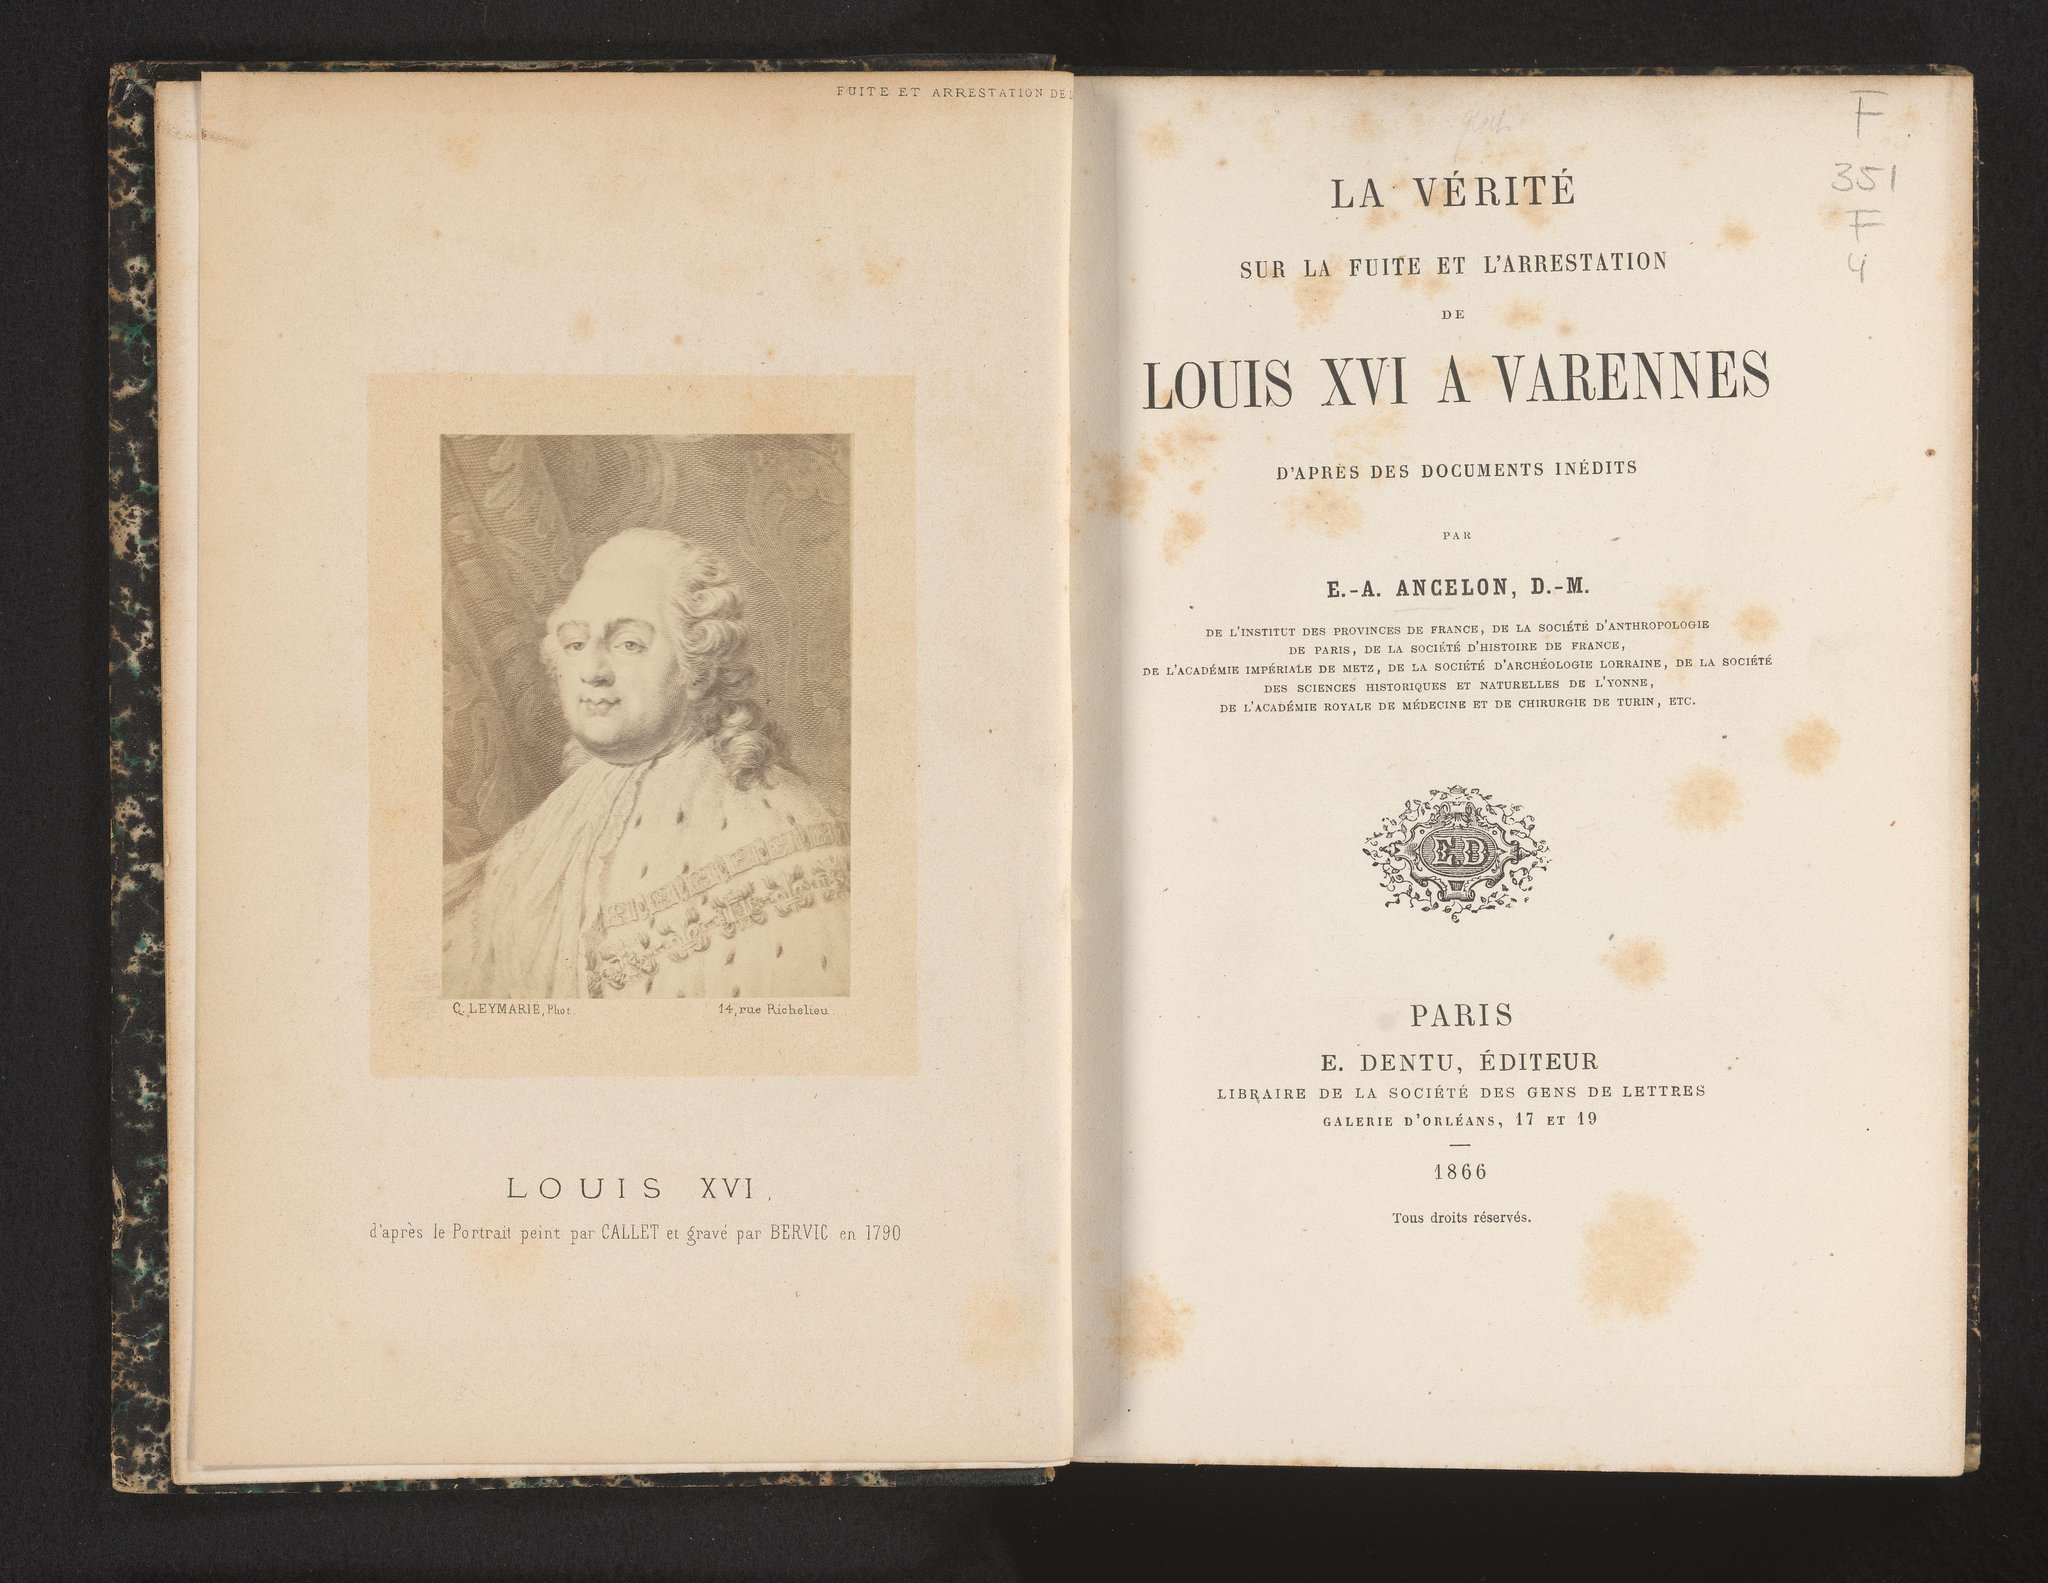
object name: reproduction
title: Fotoreproductie van een portret van Lodewijk XVI van Frankrijk naar een schilderij van Antoine-François Callet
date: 1856-1866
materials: paper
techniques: albumen print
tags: paris, lodewijk xvi (koning van frankrijk), historical persons, king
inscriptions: address: ‘14, rue Richelieu’